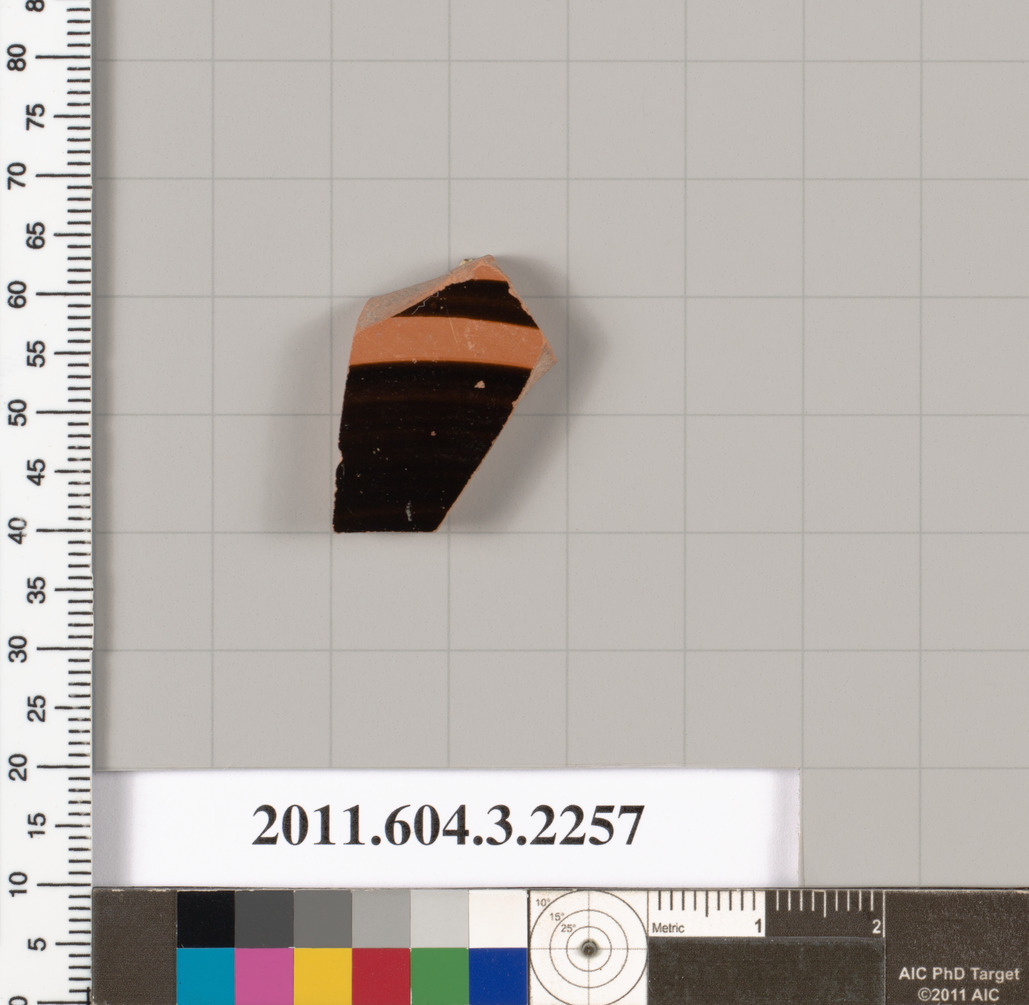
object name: kylix fragment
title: Terracotta fragment of a kylix (drinking cup)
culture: greek, attic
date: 600-401 BCE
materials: terracotta